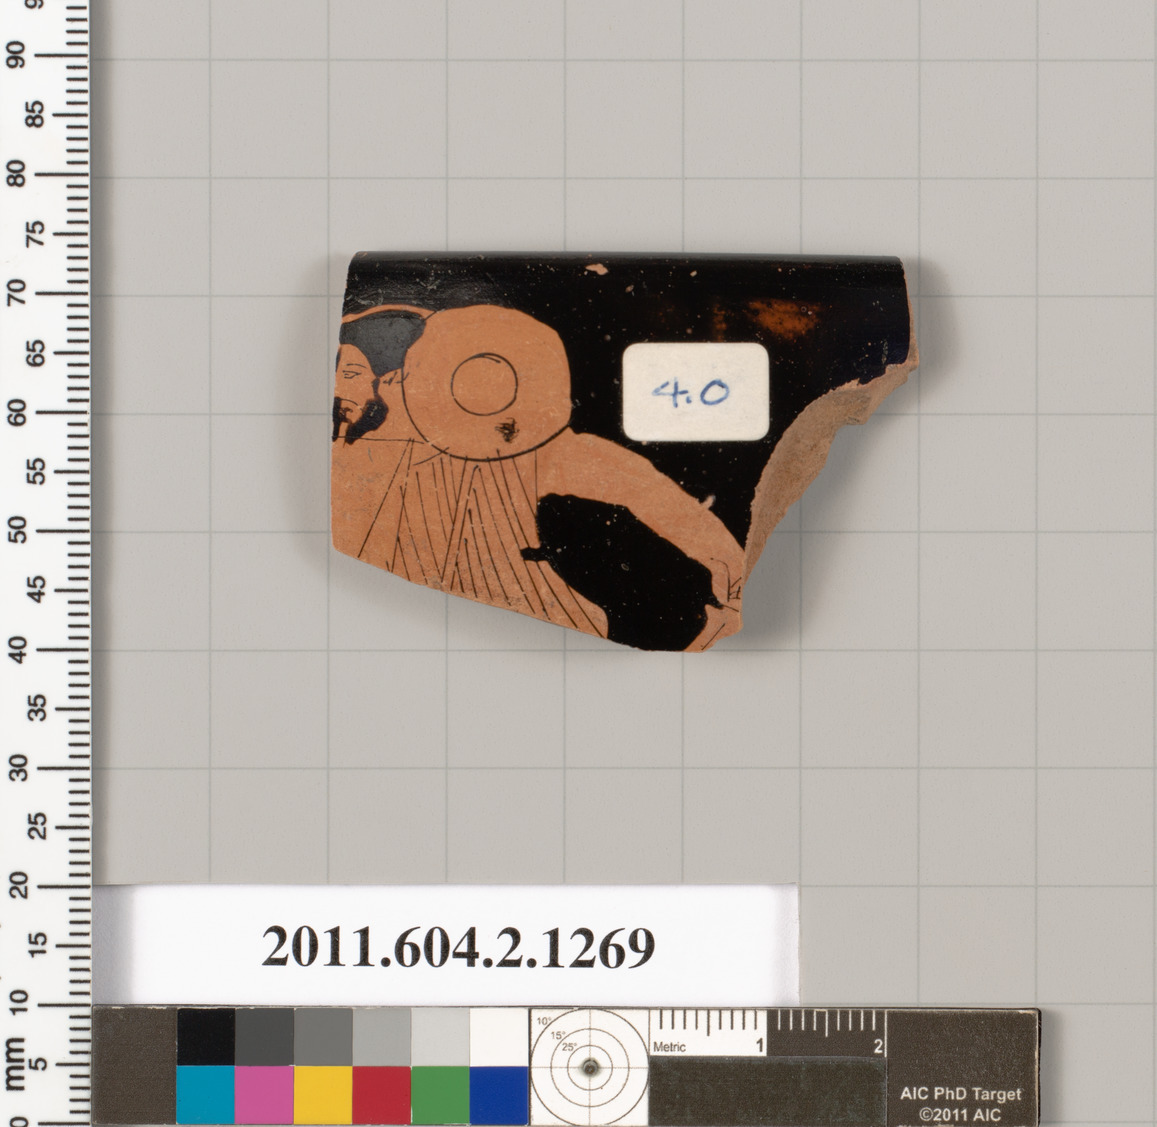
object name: skyphos fragment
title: Terracotta rim fragment of a skyphos (deep drinking cup)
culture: greek, attic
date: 475-451 BCE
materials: terracotta